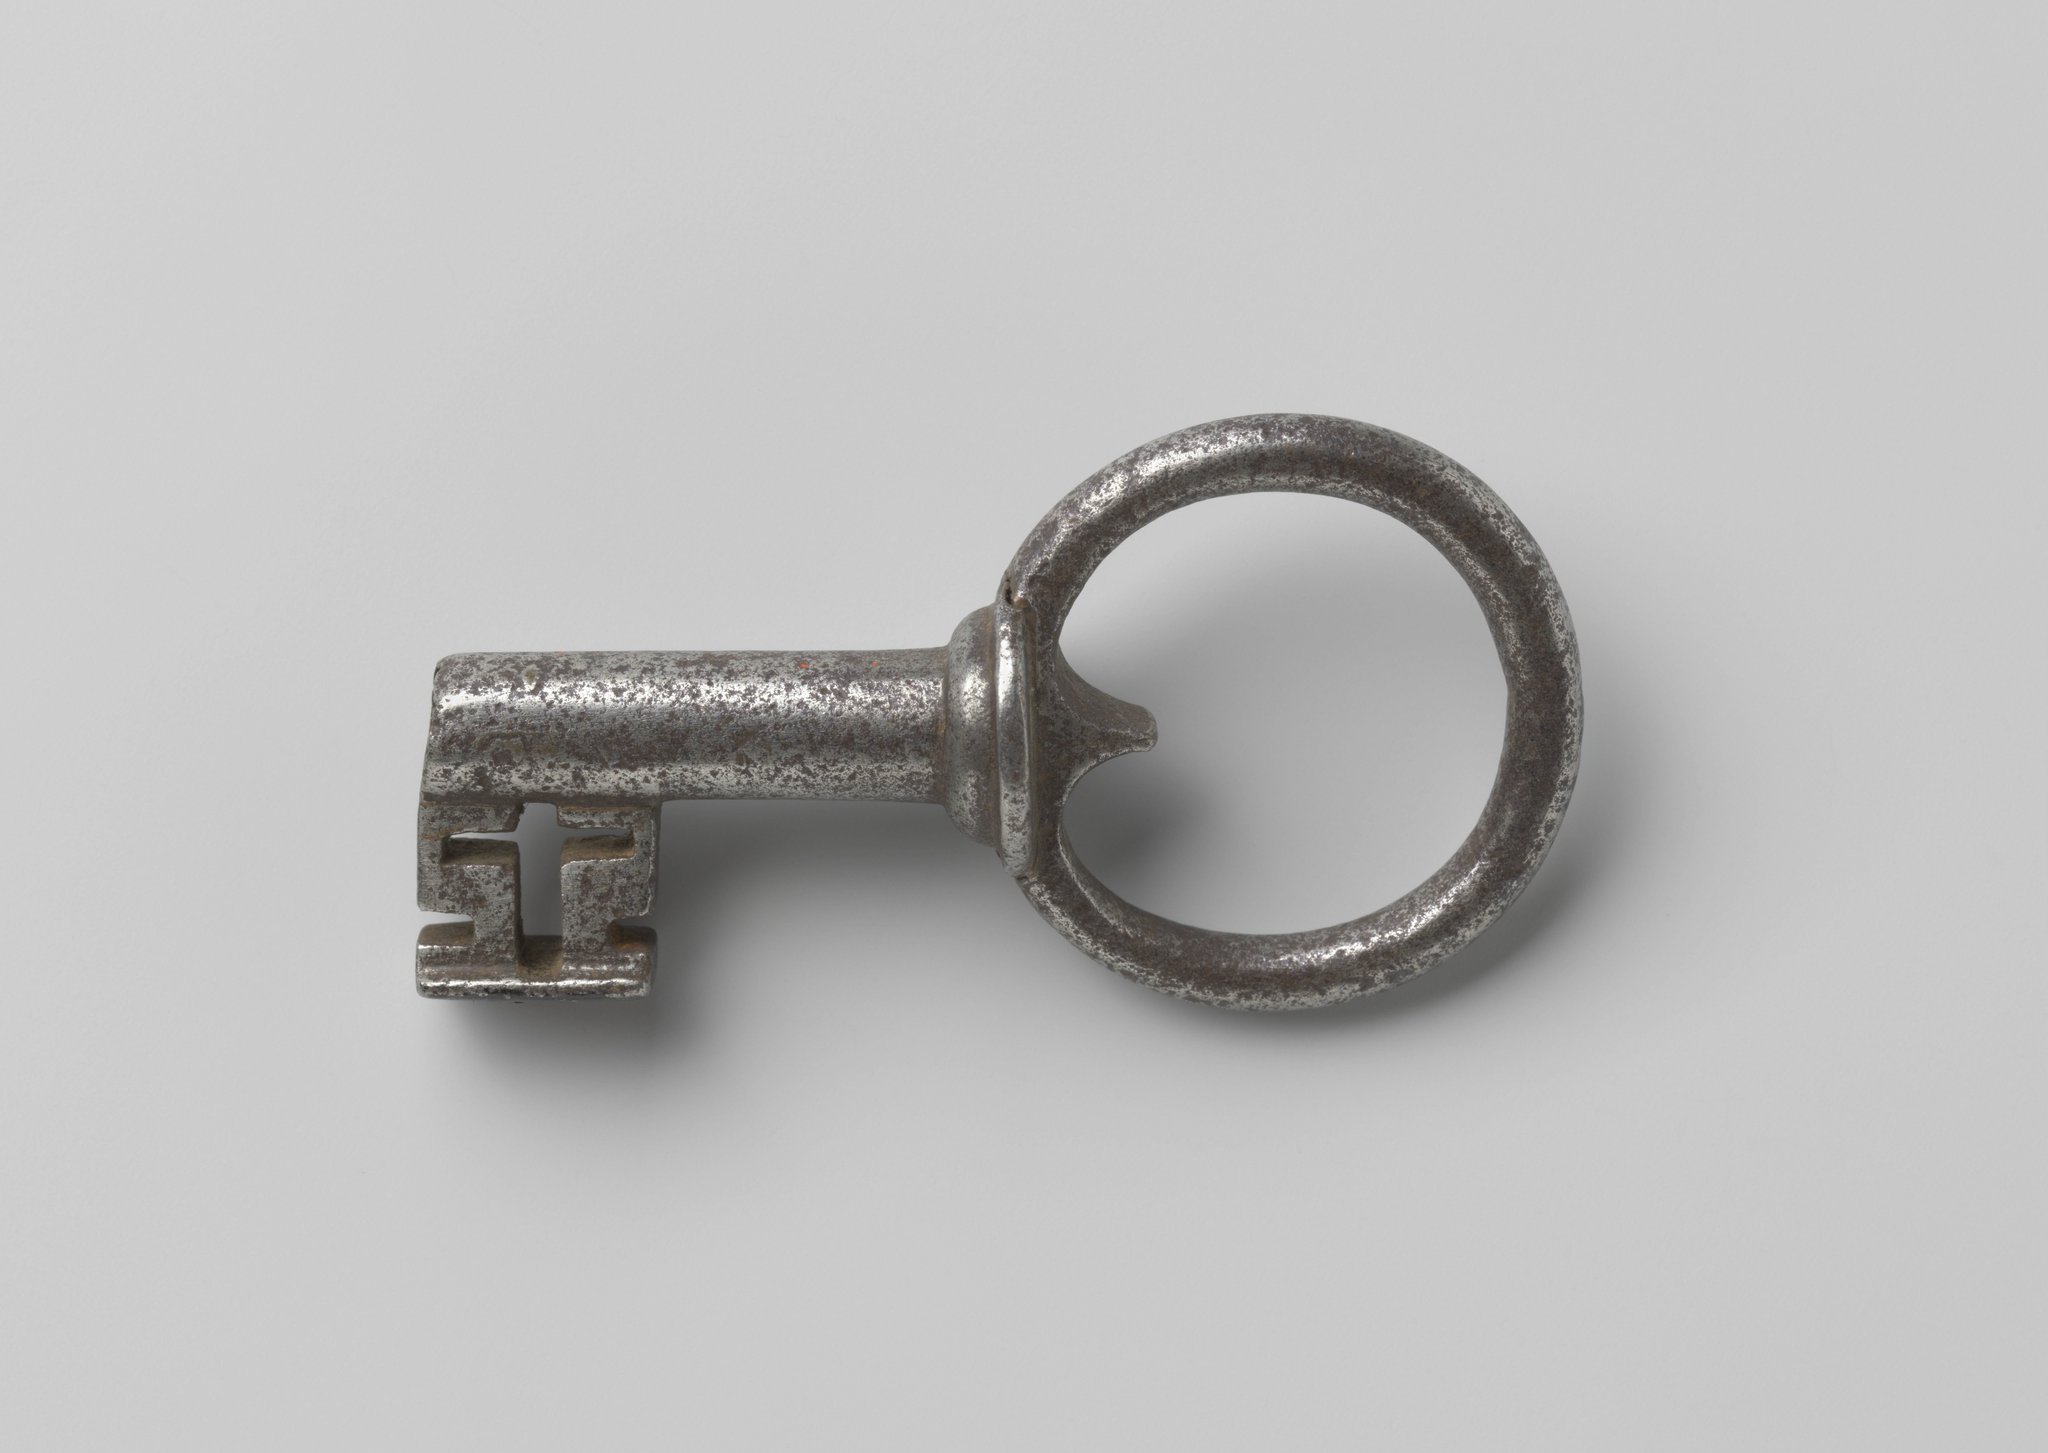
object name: pipe key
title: Pijpsleutel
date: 1600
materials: iron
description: Pijpsleutel waarvan het ringvormig oog boven de schijf op het kapiteel een puntige verhoging insluit. Korte schacht.